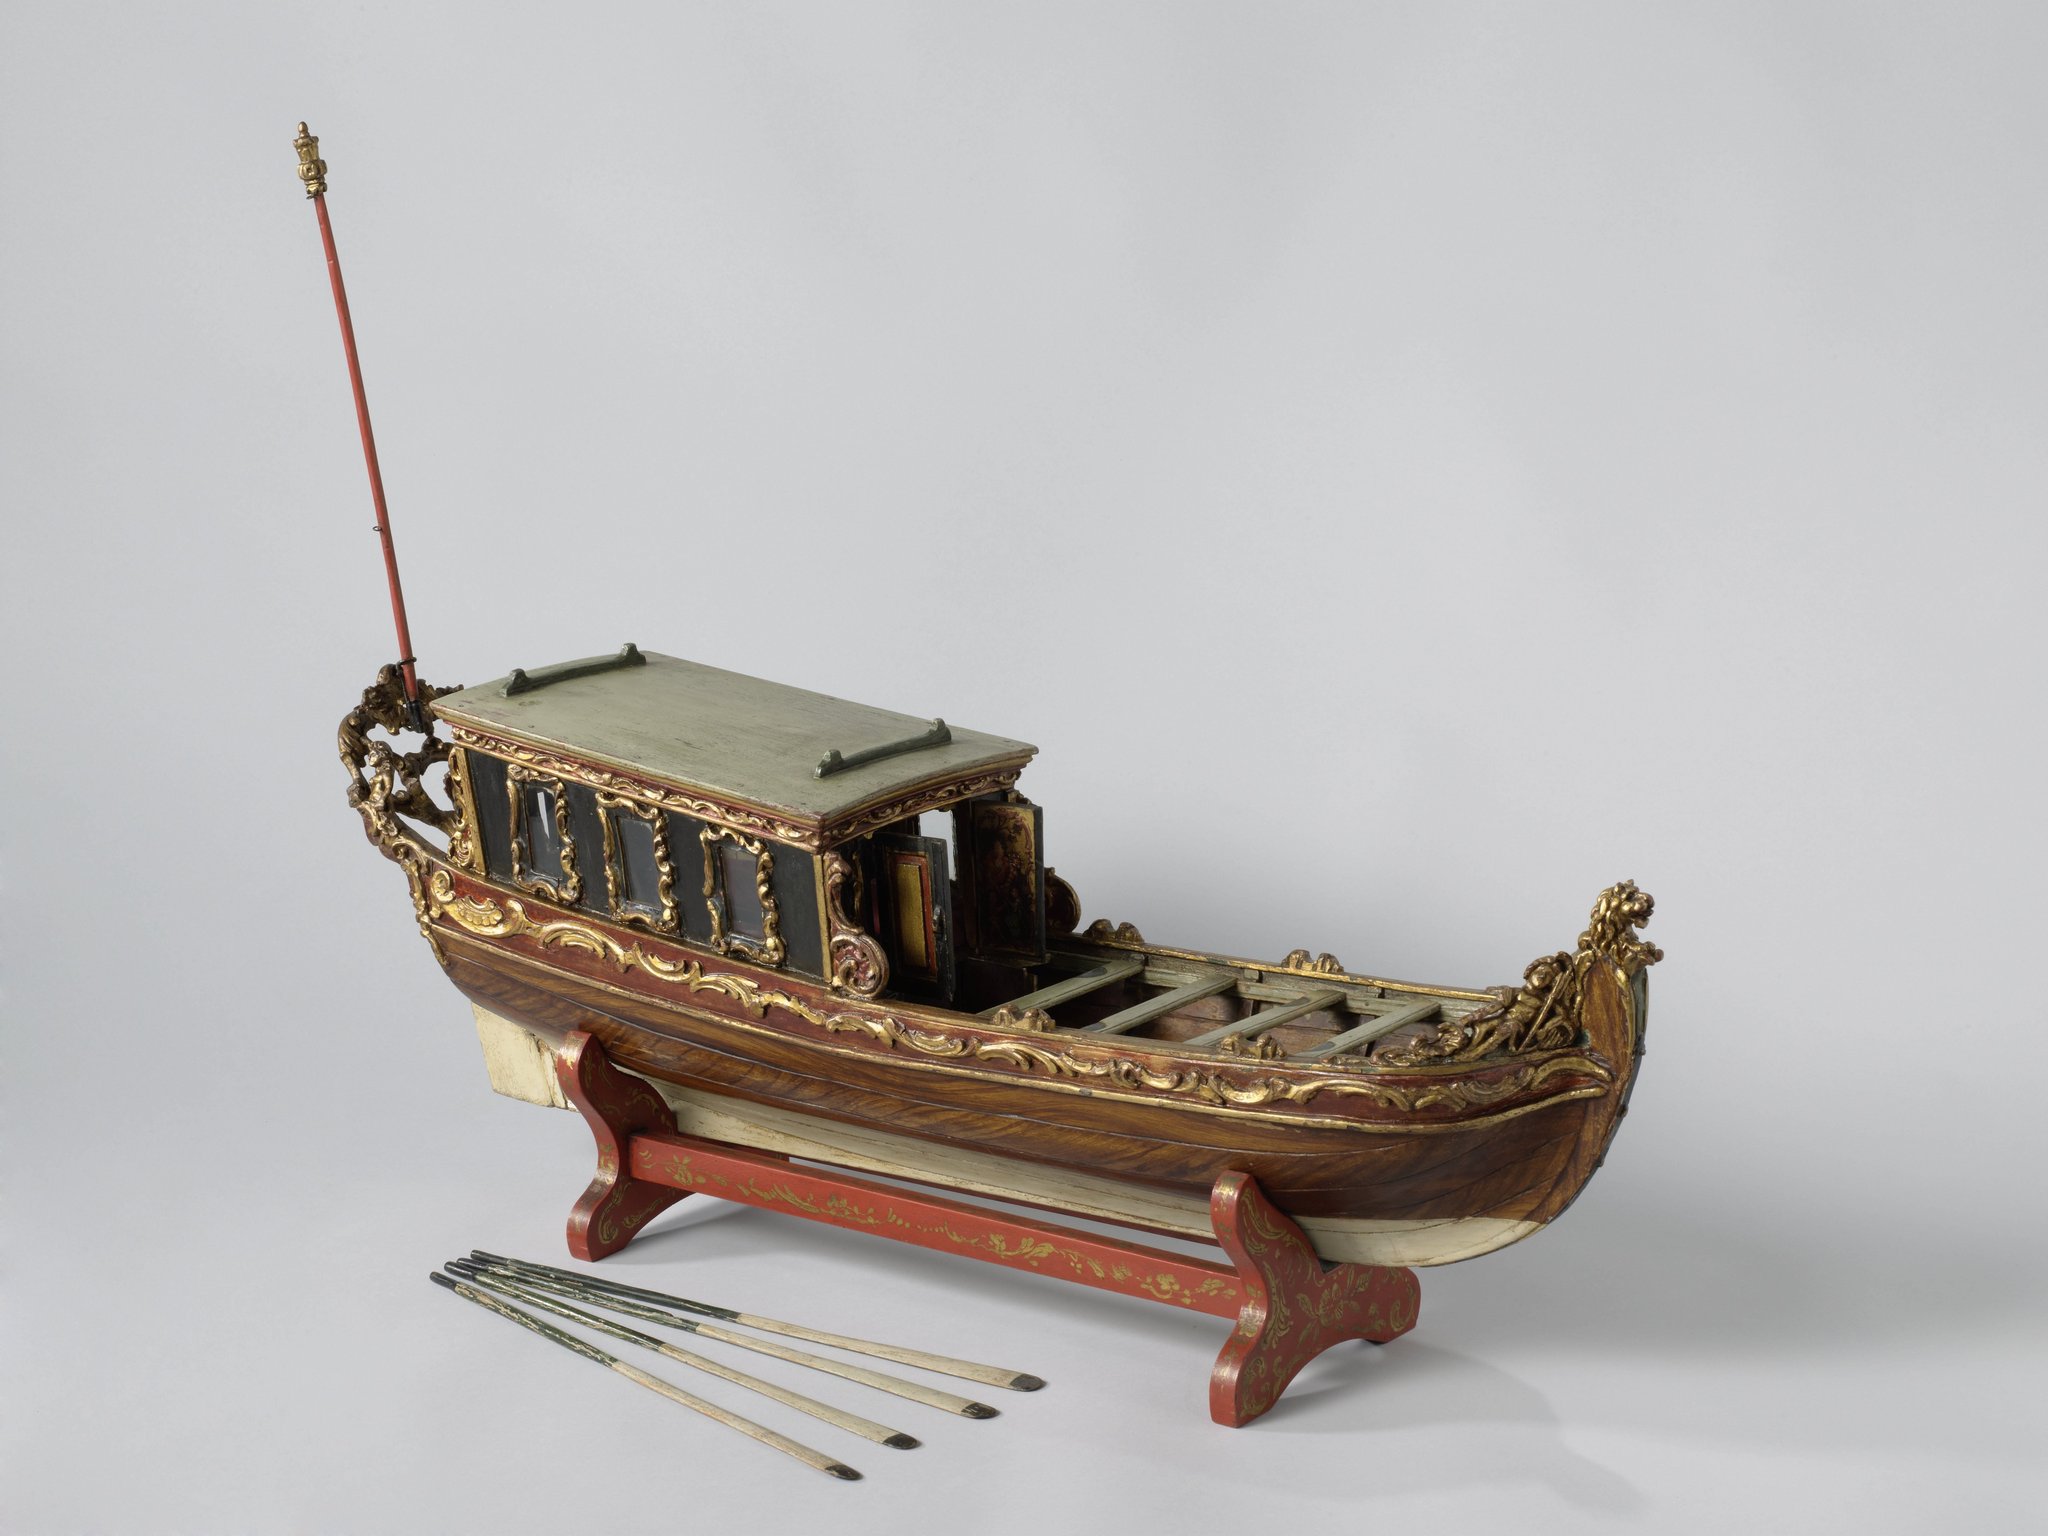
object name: show model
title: Model of a Gentleman's Yacht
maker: Anonymous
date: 1700-1800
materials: copper, glass, silk, metal, wood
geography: netherlands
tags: ship-model (+ propulsion of vehicle, ship, etc. by human power)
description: Sloep, staande op een houten rode standaard met verguldsel. De zijkanten, de roef, de spiegel en de scheg versierd met vergulde rocaille motieven. Het schegbeeld gevormd door een leeuwenkop. De sloep bevat 4 groengeschilderde roeibanken en 4 riemen. In de roef, die aan weerskanten 3 ruitjes bevat, 2 lange banken met rood zijden kussens. De binnenzijden van de deurtjes zijn beschilderd met allegorische voorstellingen, evenals het plafond van de roef. Op één deur prijkt het wapen van Amsterdam. Roer versierd.